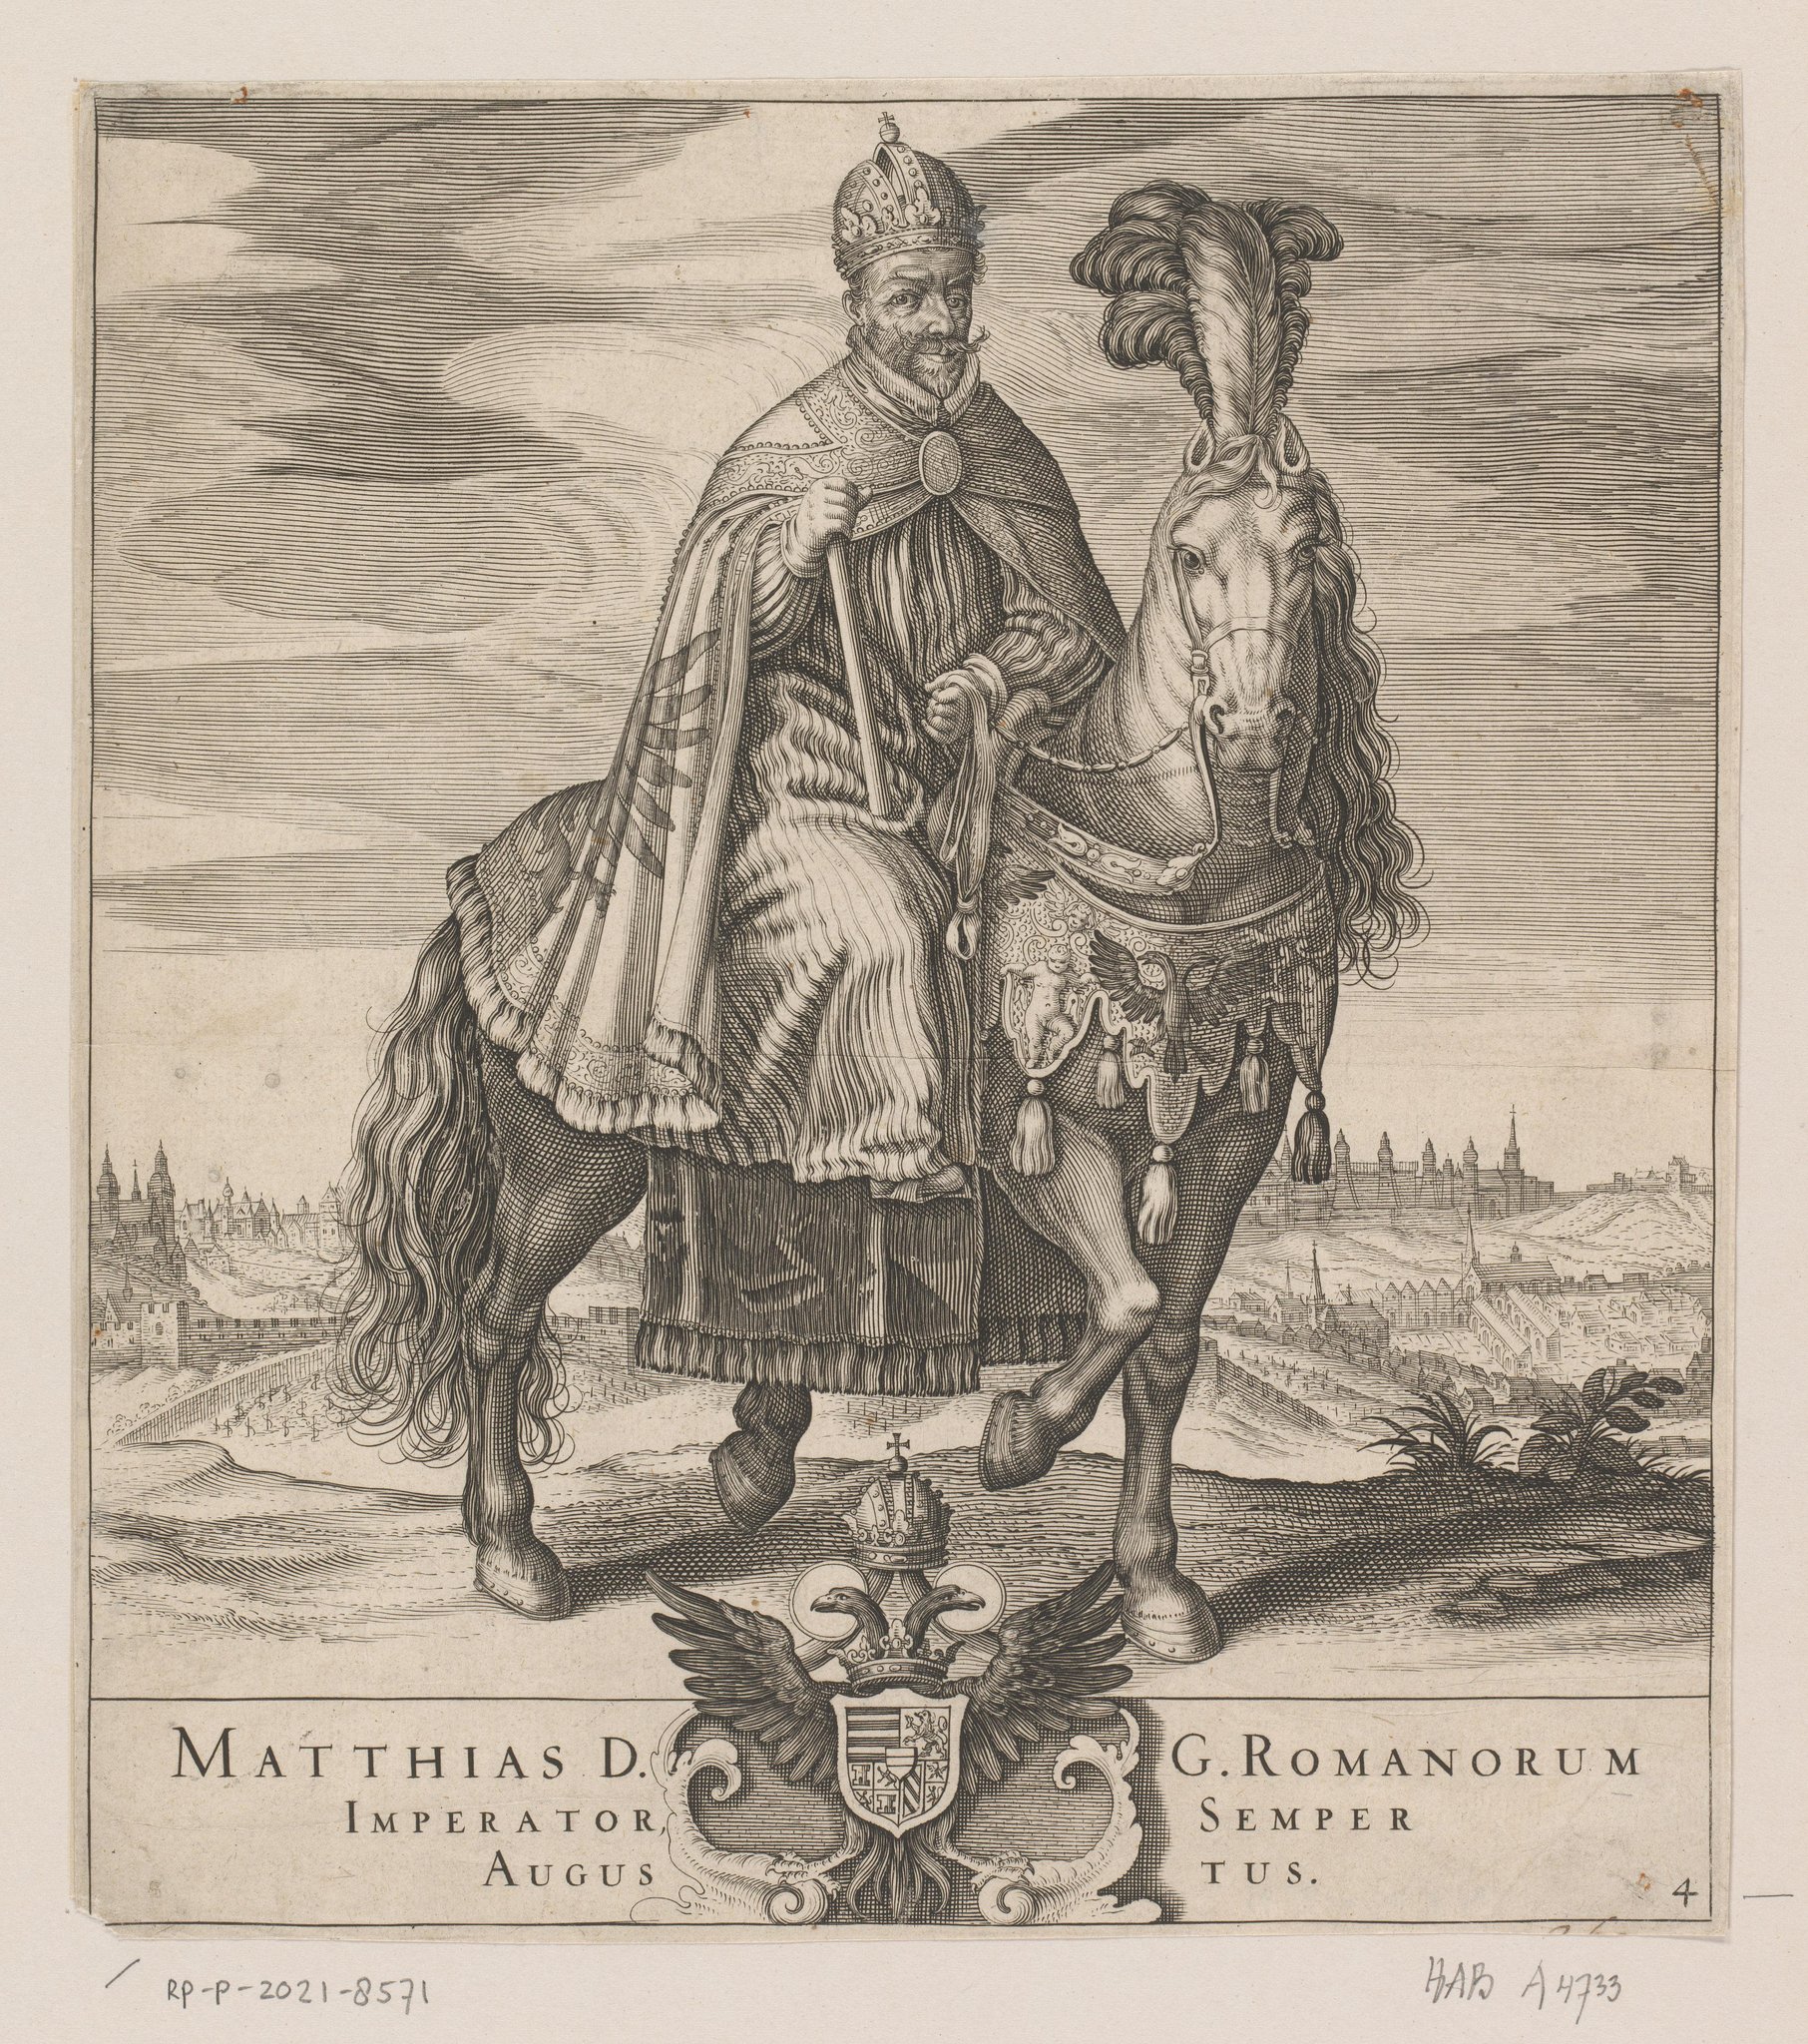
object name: print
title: Ruiterportret van keizer Matthias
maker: Anonymous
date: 1612-1680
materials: paper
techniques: engraving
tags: vienna, matthias van oostenrijk (rooms-duits keizer), equestrian state-portrait, historical persons, emperor, armorial bearing, heraldry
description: Met onderschrift in het Latijn. Rechtsonder genummerd: 4.